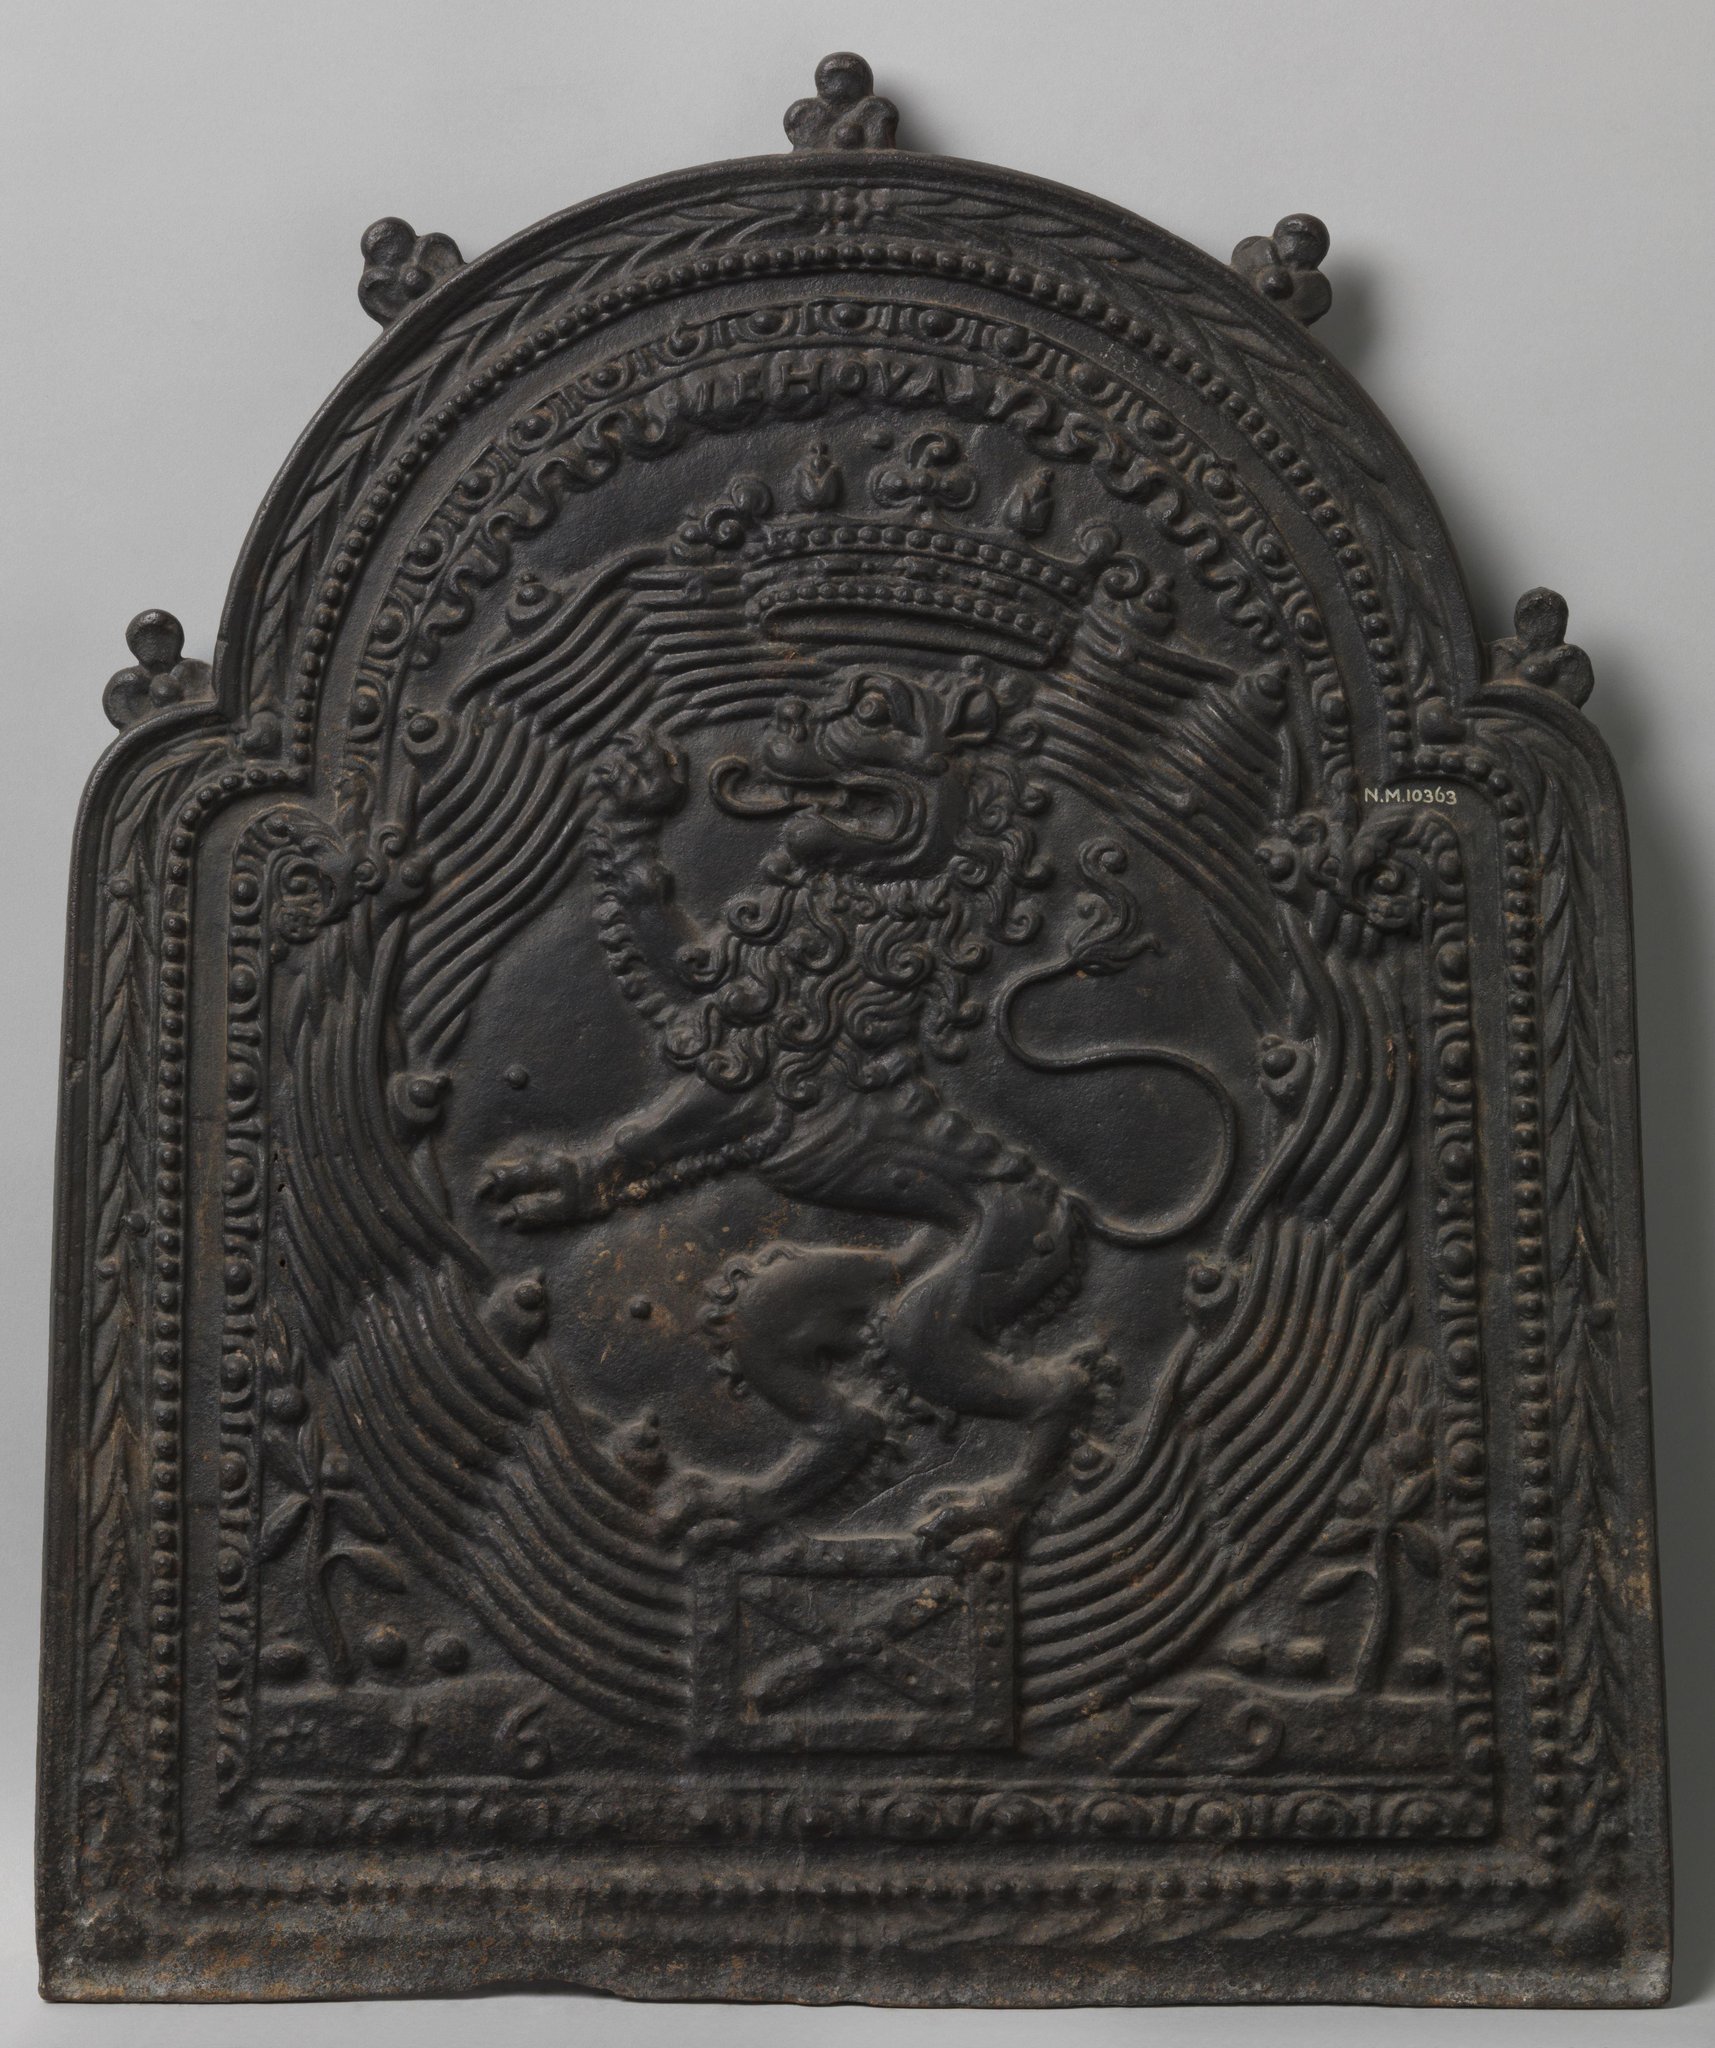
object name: fireback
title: Haardplaat met Hollandse leeuw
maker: Anonymous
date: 1629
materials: iron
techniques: casting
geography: germany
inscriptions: inscription: ‘1629’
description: haardplaat van gietijzer, met een halfronde bovenzijde. Centraal staat de gekroonde Hollandse Leeuw in de besloten Hollande Tuin met vooraan een toeganspoort. Aan weerszijden het jaartal 1629. Het geheel is omringd door meerdere sierbanden, respectievelijk van binnen naar buiten een eierlijst, een parelrand en een touwachtige band. Bovenaan wordt het geheel bekroond met vijf keer een klavervorm.